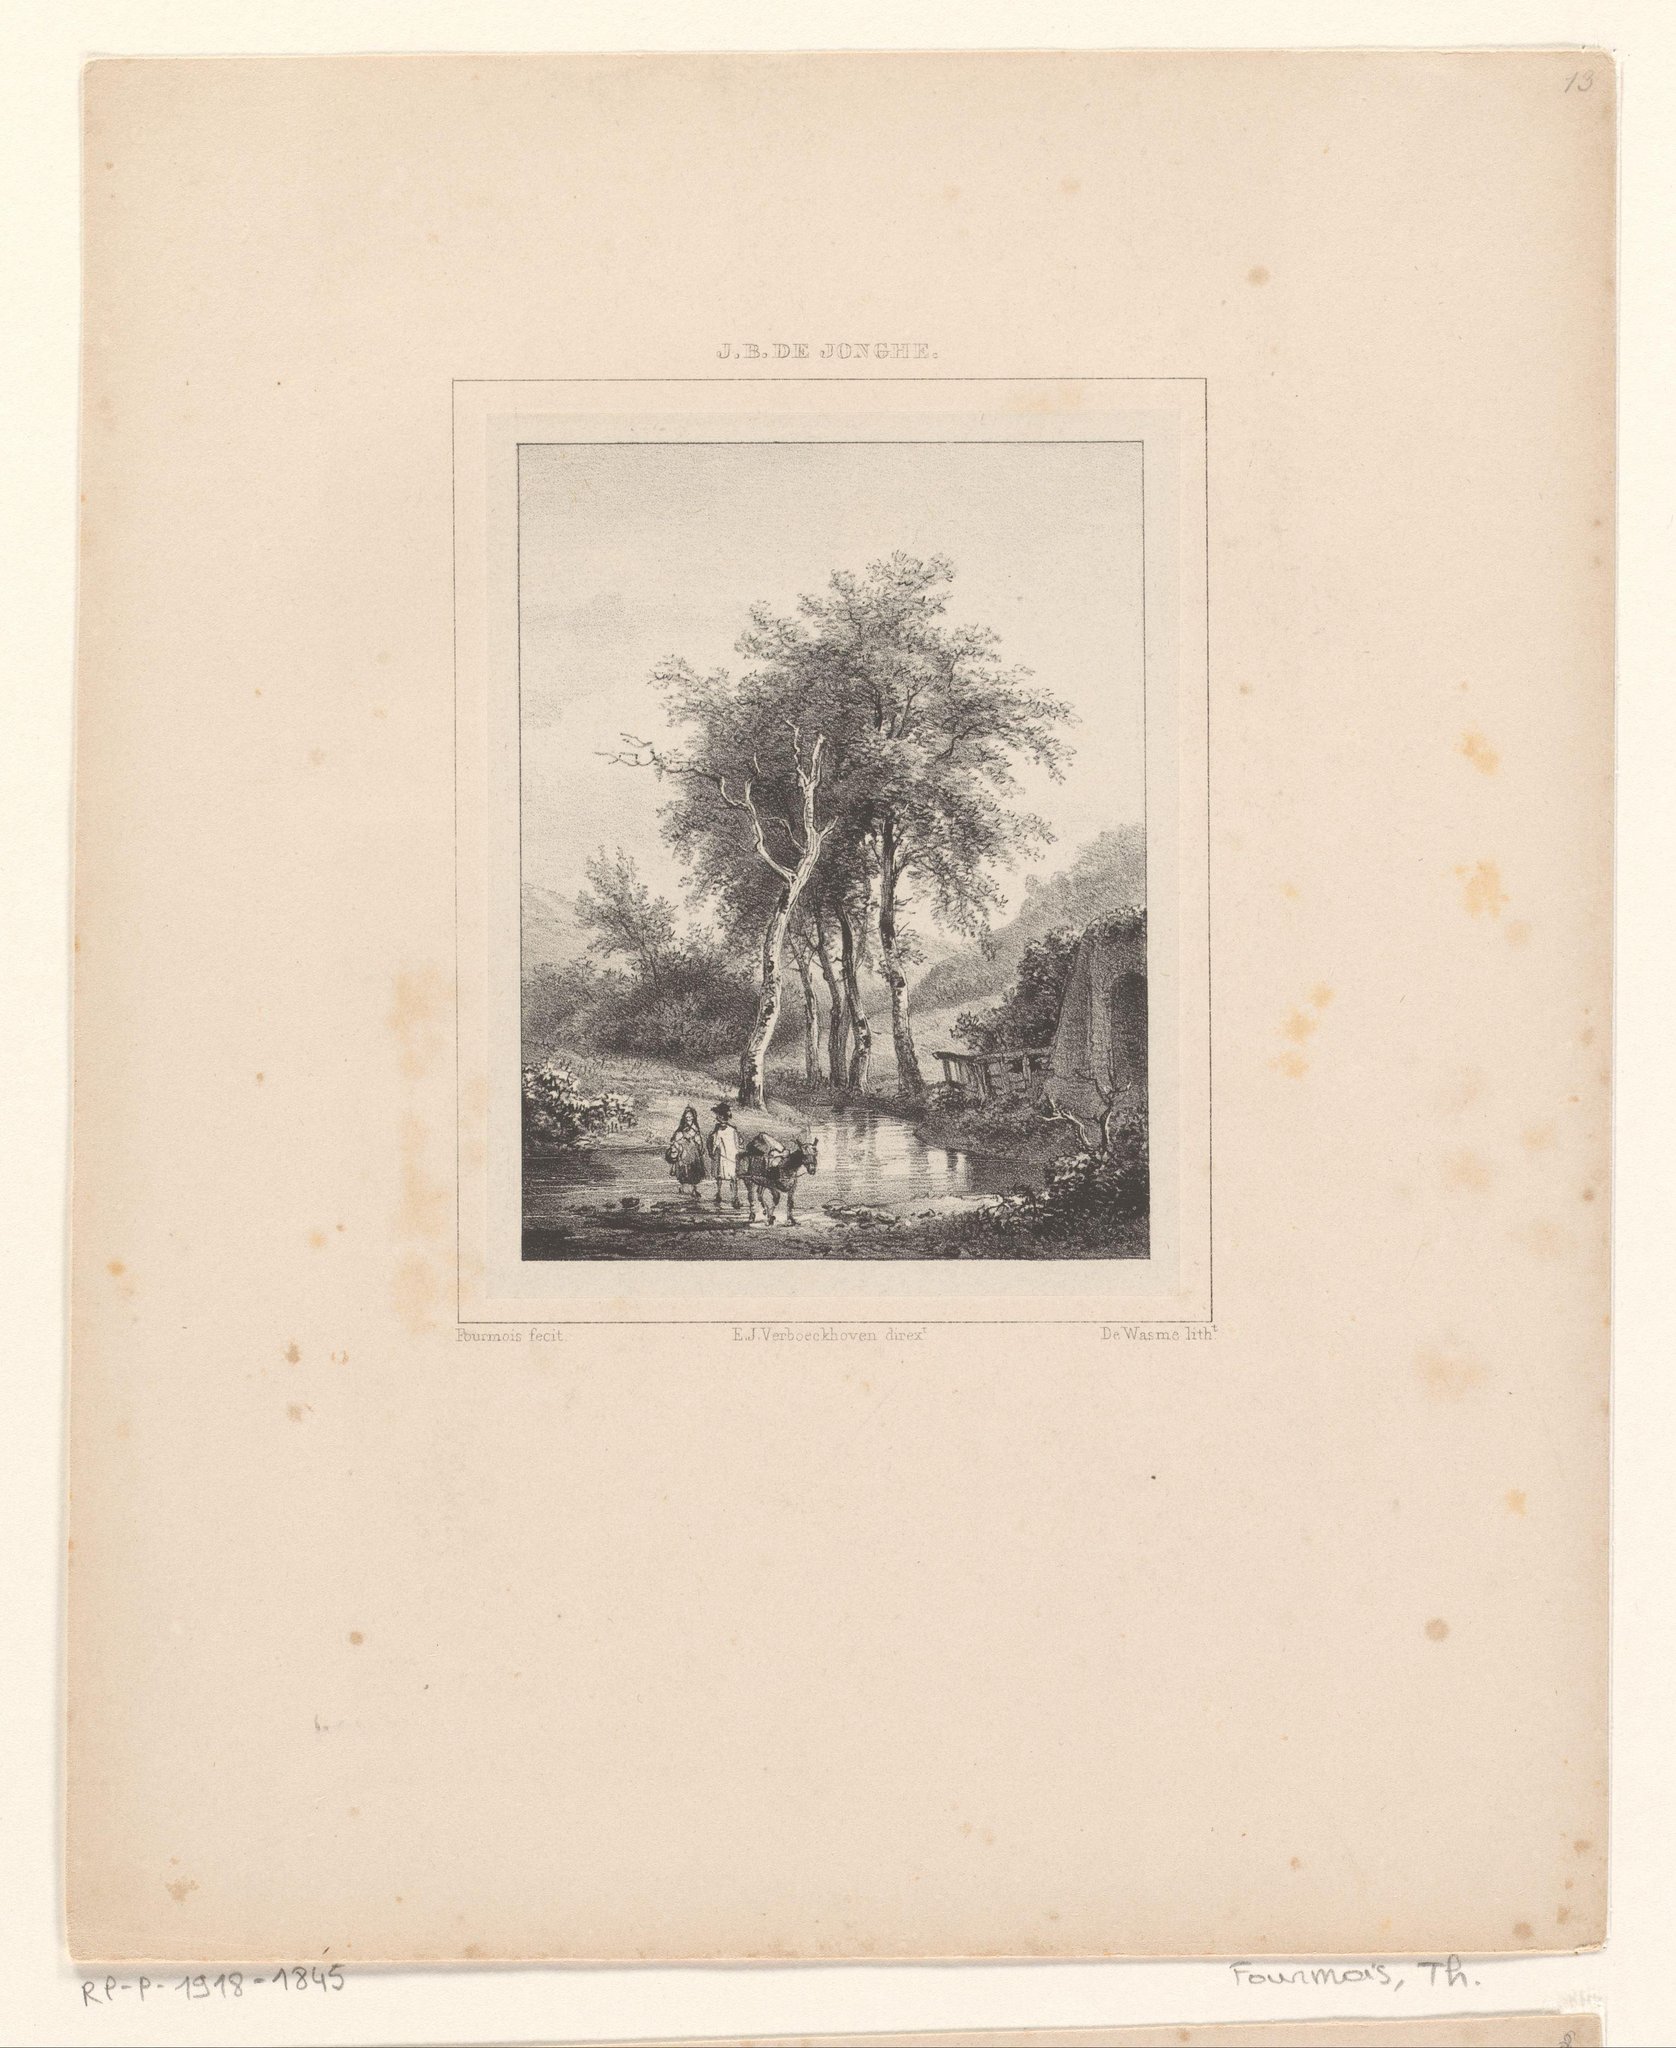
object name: print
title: Taferelen naar werken van andere kunstenaars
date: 1825-1827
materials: paper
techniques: lithograph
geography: brussels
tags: ass, donkey, landscapes with waters, waterscapes, seascapes (in the temperate zone) (+ landscape with figures, staffage)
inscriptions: collector's mark: Lugt 2233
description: Prent maakt waarschijnlijk deel uit van een serie met taferelen naar andere kunstenaars. Over deze serie is verder niets bekend.